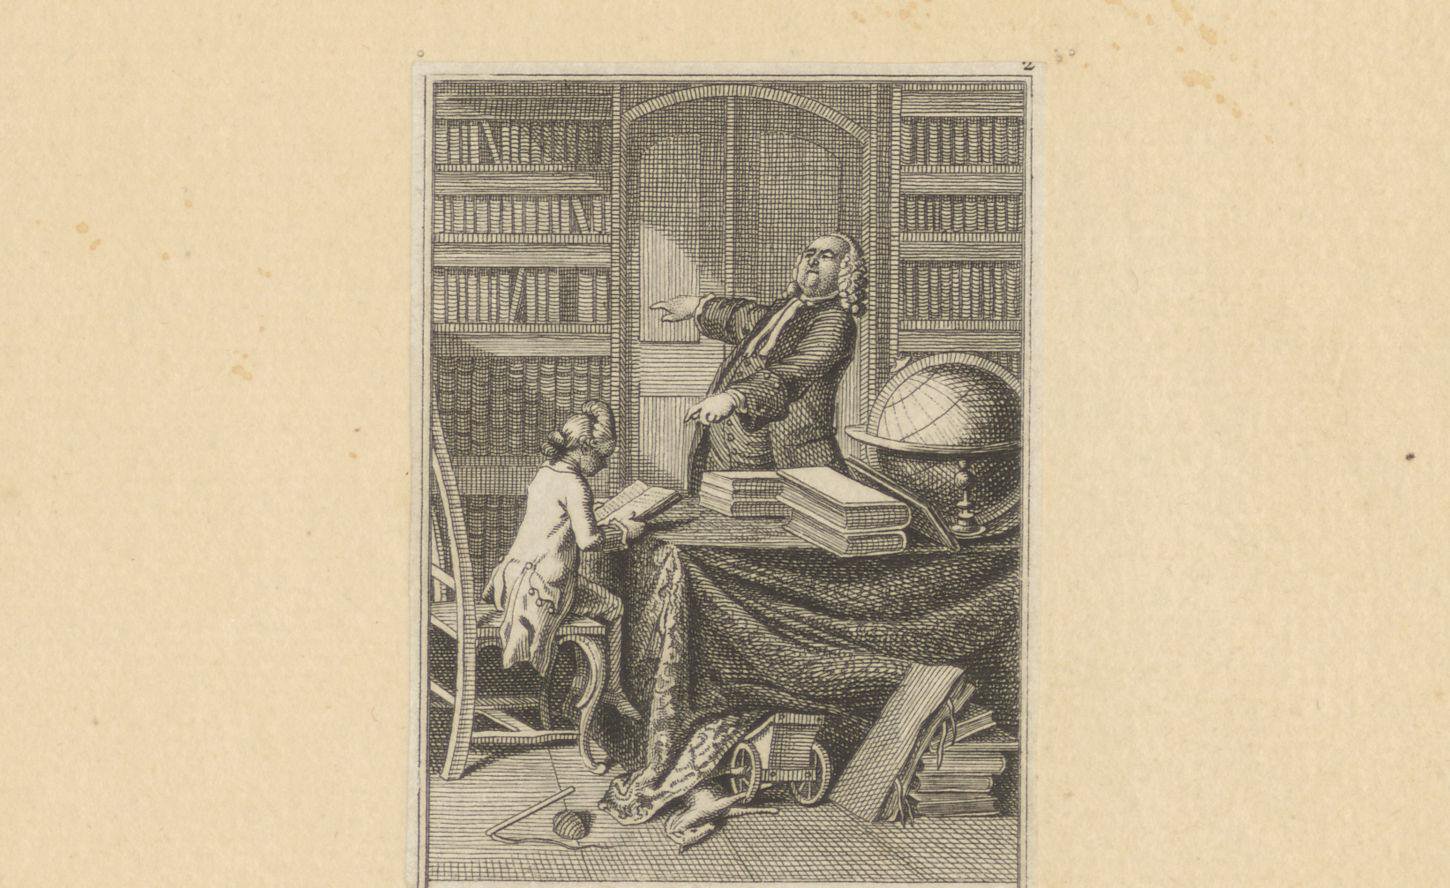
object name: book illustration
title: Fürtrefliche Bildung des Geistes und des Herzens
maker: daniel berger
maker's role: print maker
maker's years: 1744-1824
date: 1773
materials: paper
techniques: etching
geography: berlin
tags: reading, study; 'studiolo'; library, (playing with) toys, student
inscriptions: collector's mark: Lugt 2228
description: Prent afkomstig uit: Genealogischer Calender auf das Jahr 1774. Mit Genehmigung der Königlichen Academie der Wissenschaften zu Berlin herausgegeben. Tweede scène uit de serie 'Das Leben eines Lüderlichen', bestaand uit twaalf scènes, gedrukt van een koperplaat.